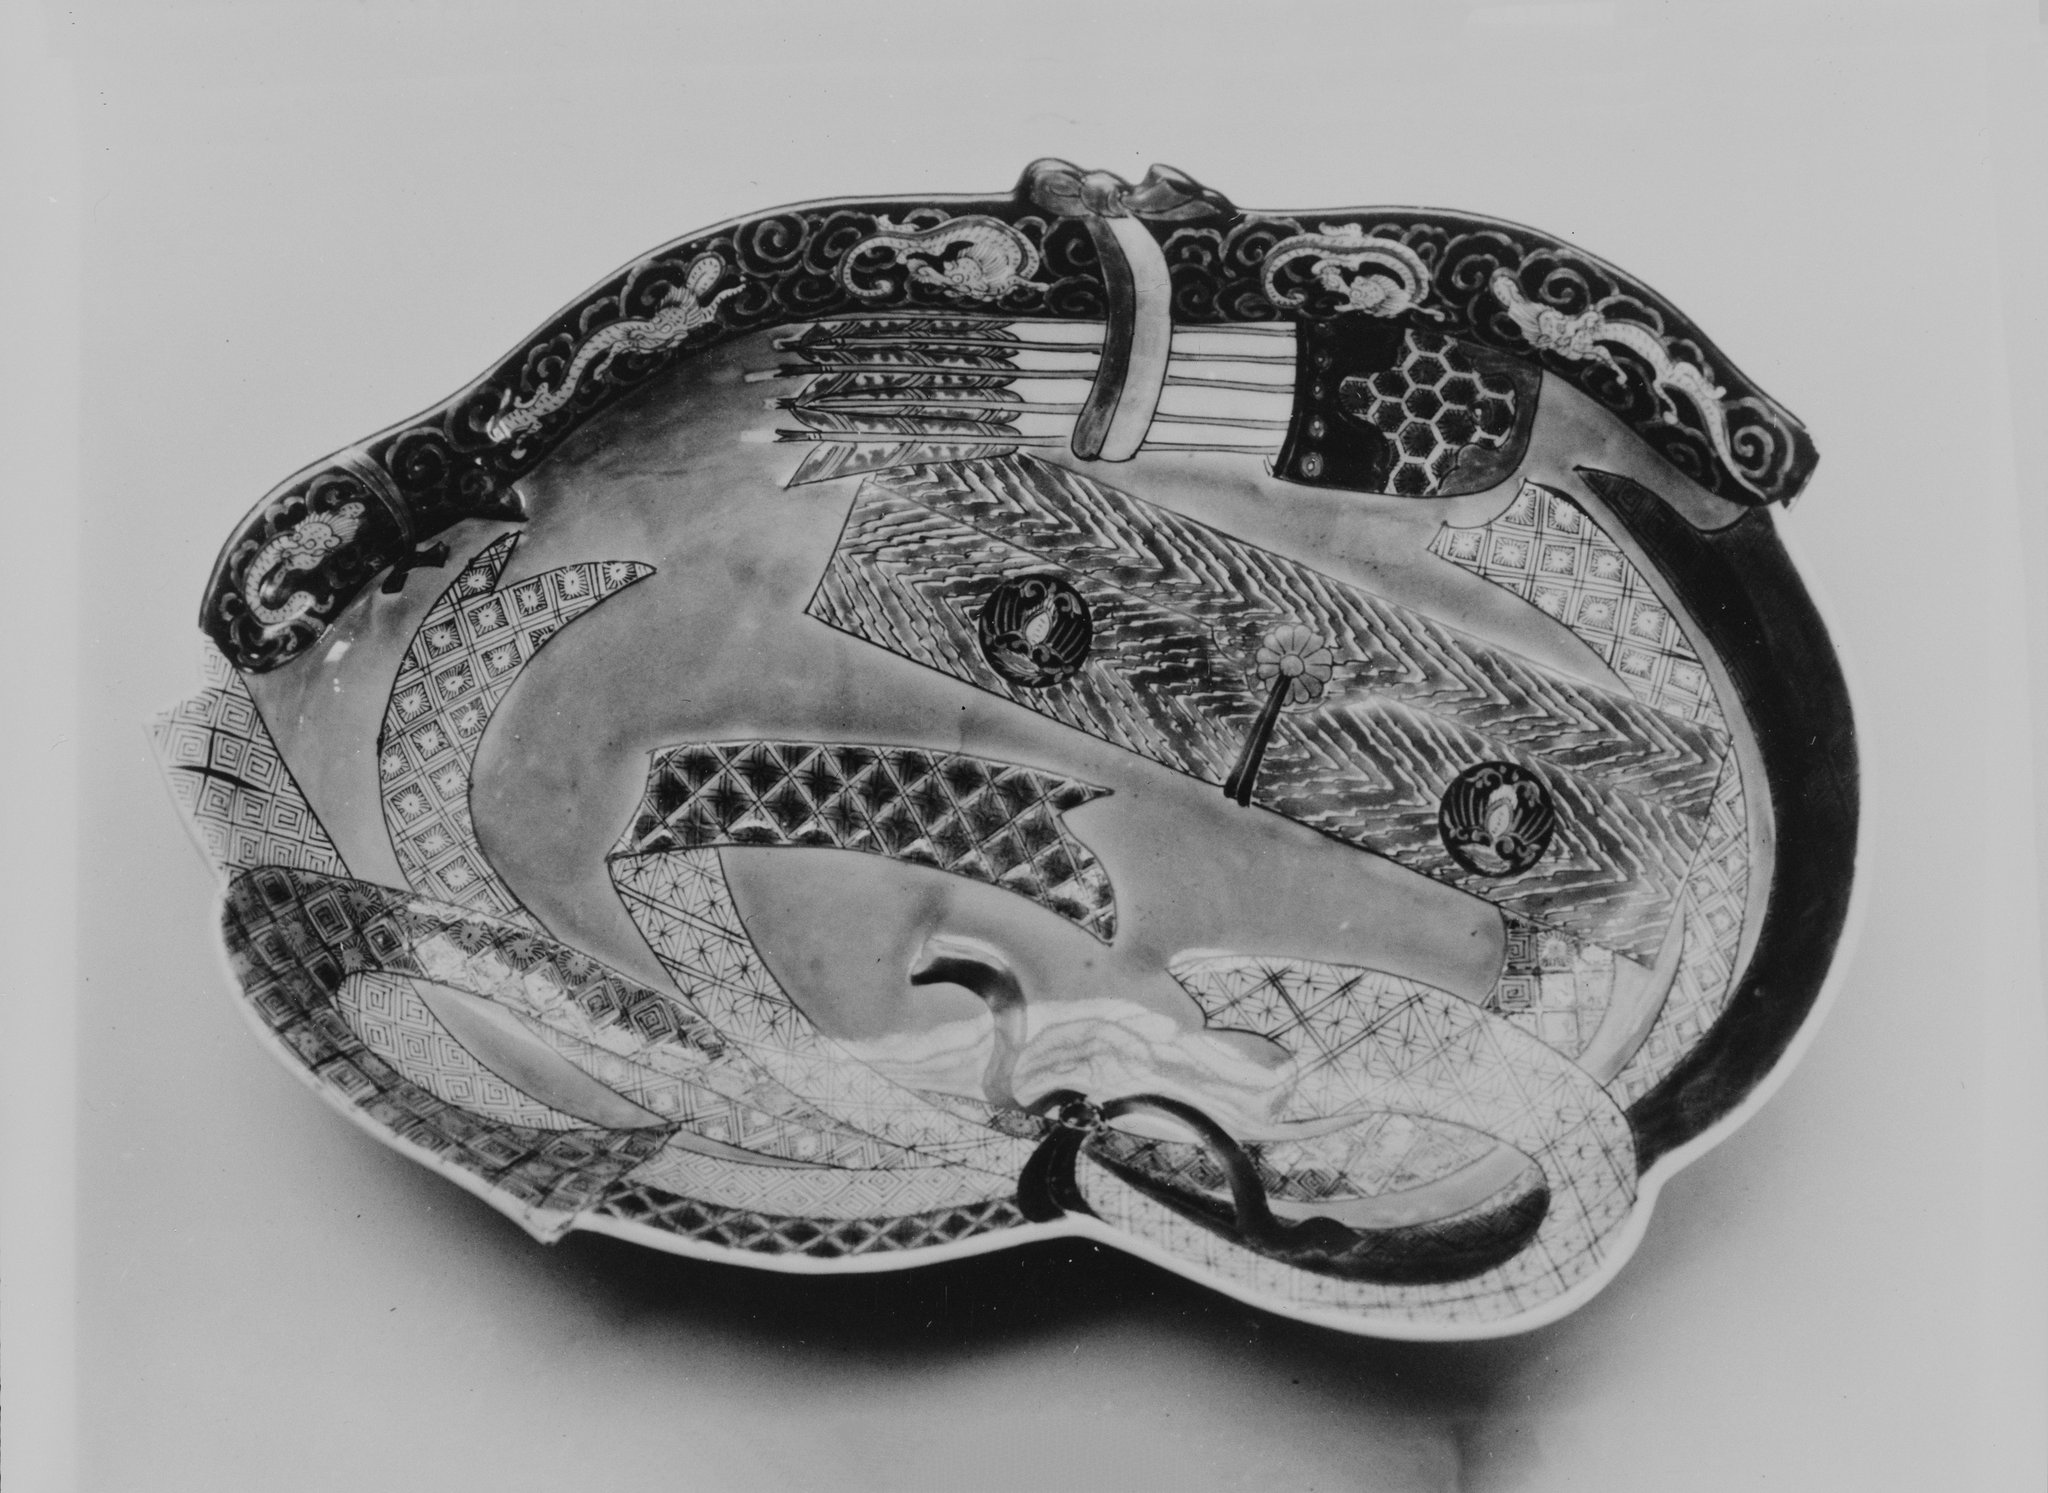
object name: plate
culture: japanese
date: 1720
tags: arrows